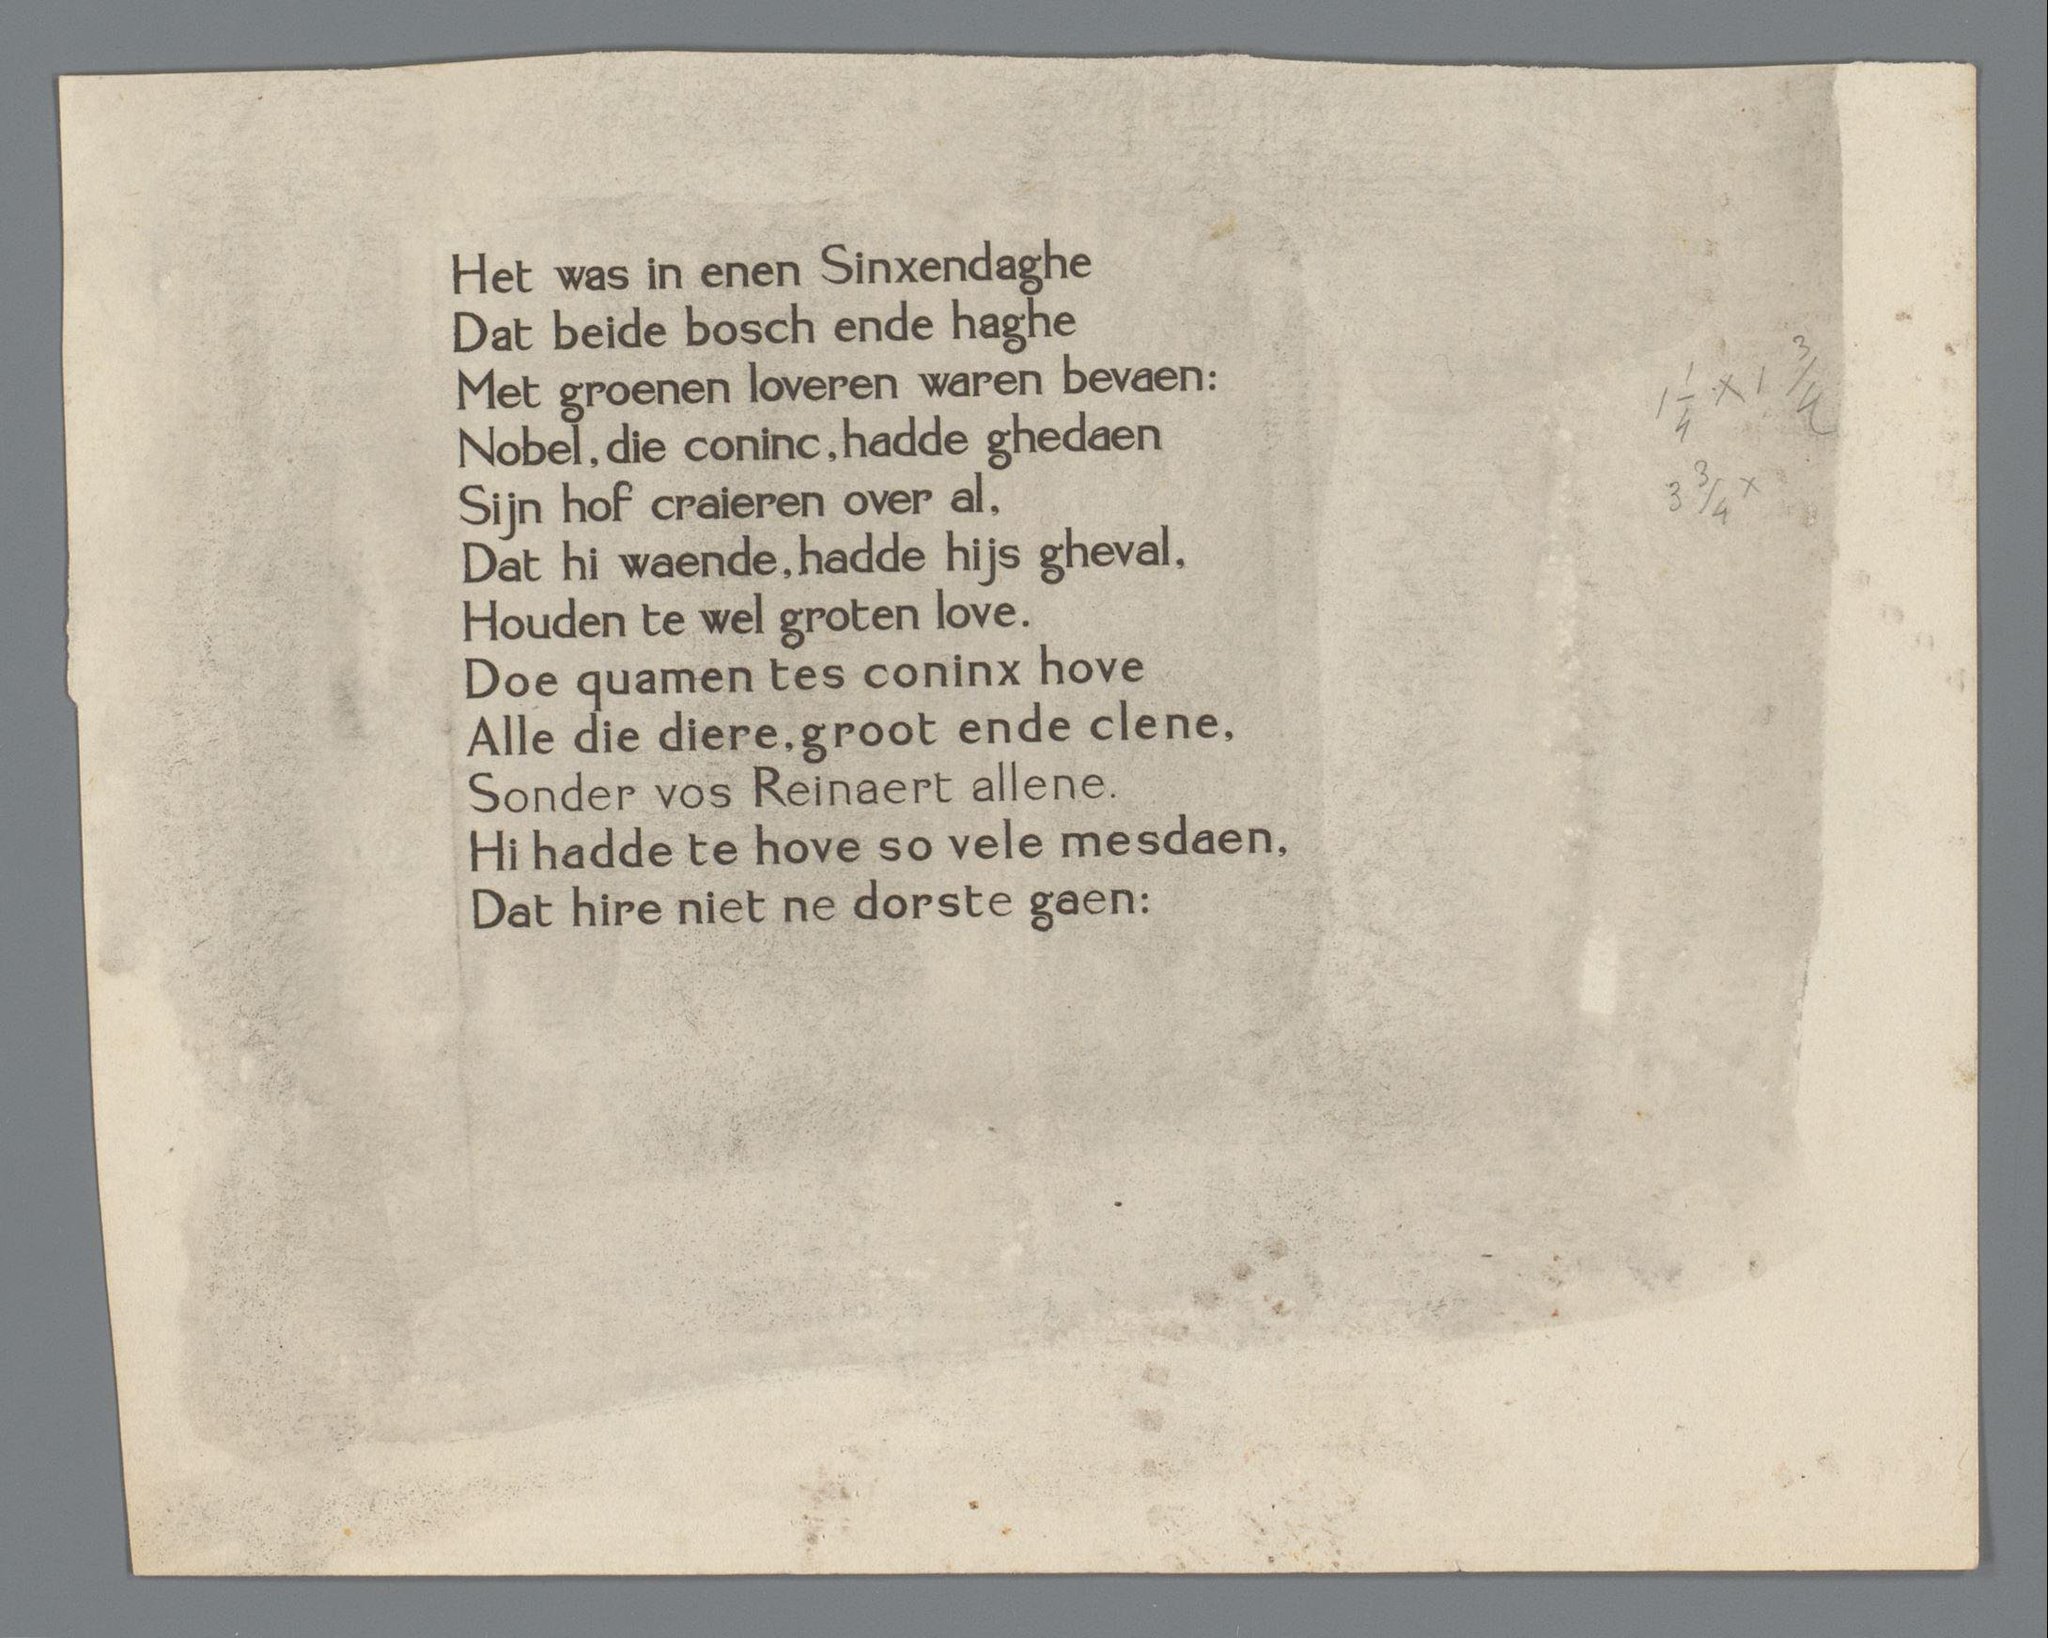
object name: text sheet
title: Proefdruk van twaalf regels van Van den vos Reynaerde in de Klei-type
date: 1896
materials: paper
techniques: photolithography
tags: printed matter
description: De hier weergegeven letter is fotolithografisch verkleind van het origineel dat door Gerrit Willem Dijsselhof in hout gesneden werd.